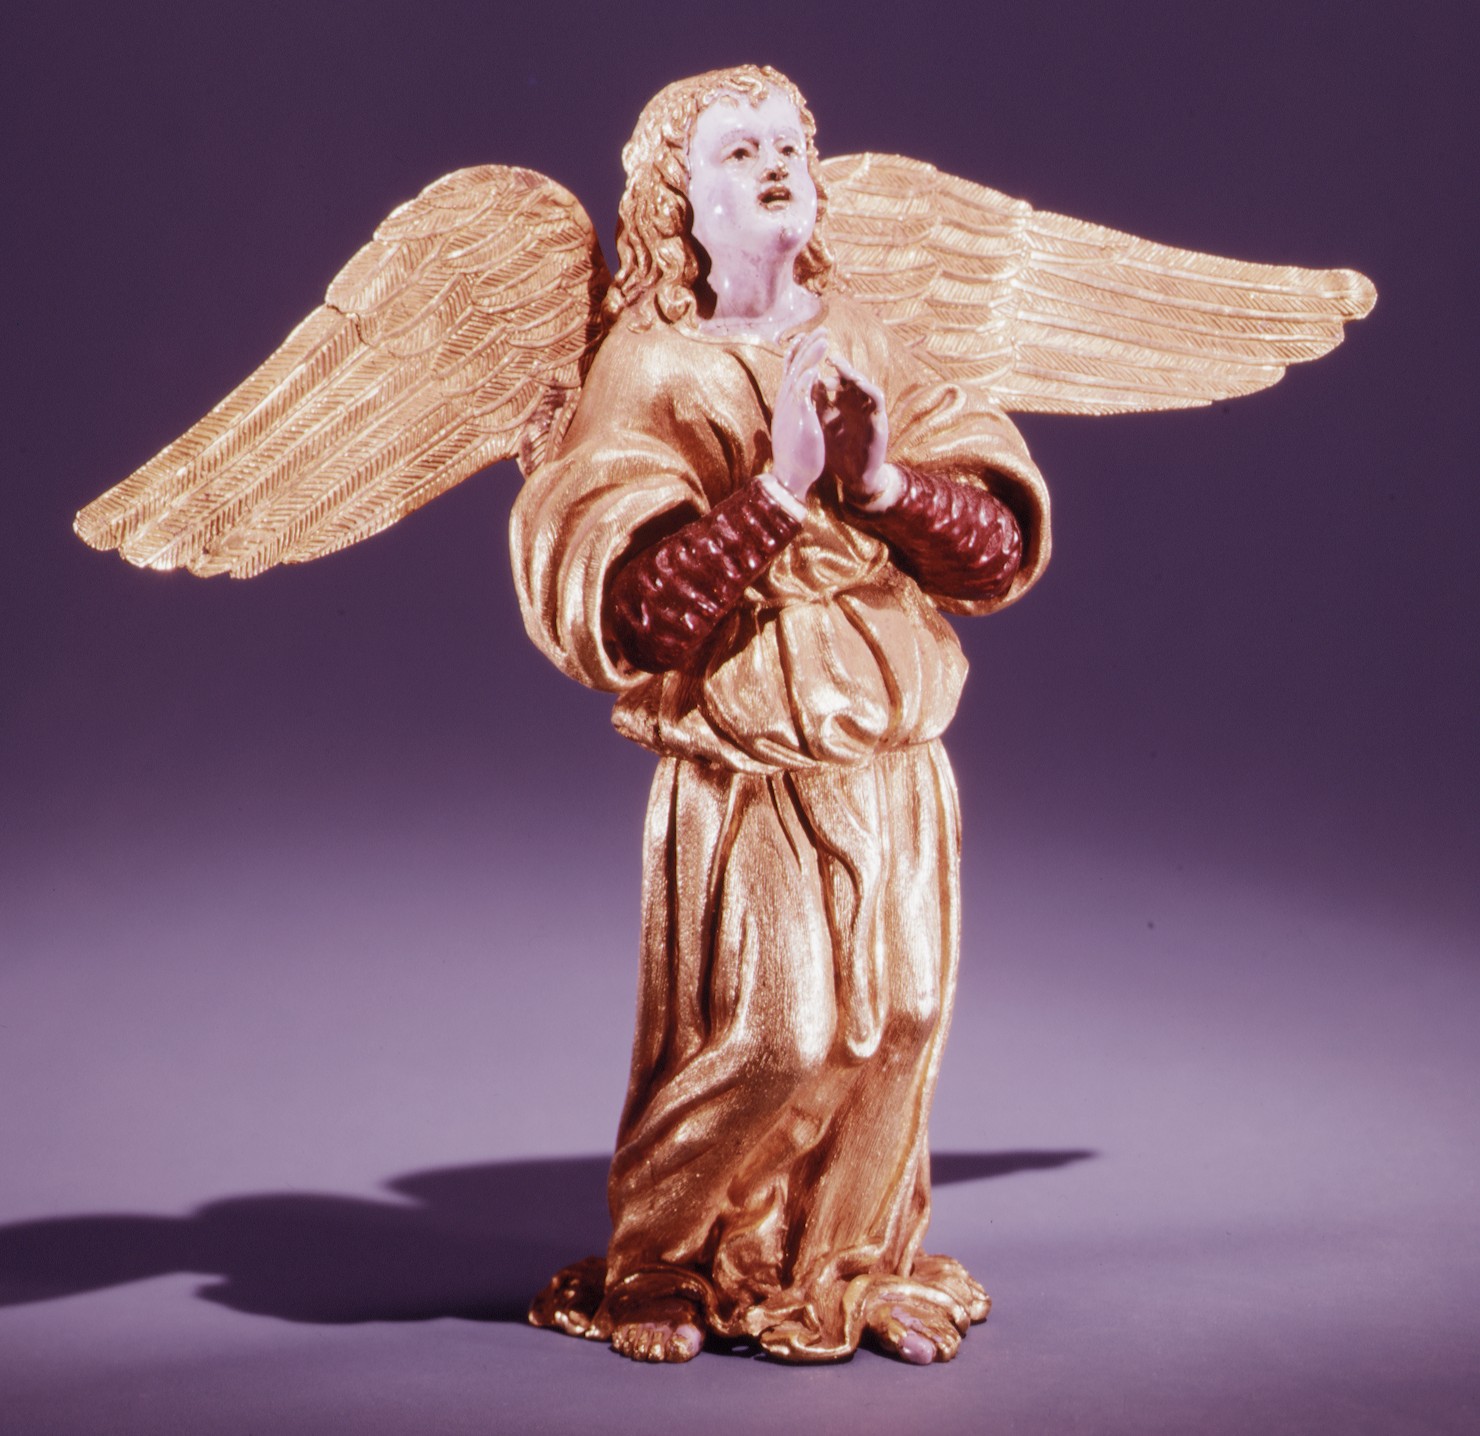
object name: figure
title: Adoring angel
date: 1476-1500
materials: gold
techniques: enamel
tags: angels